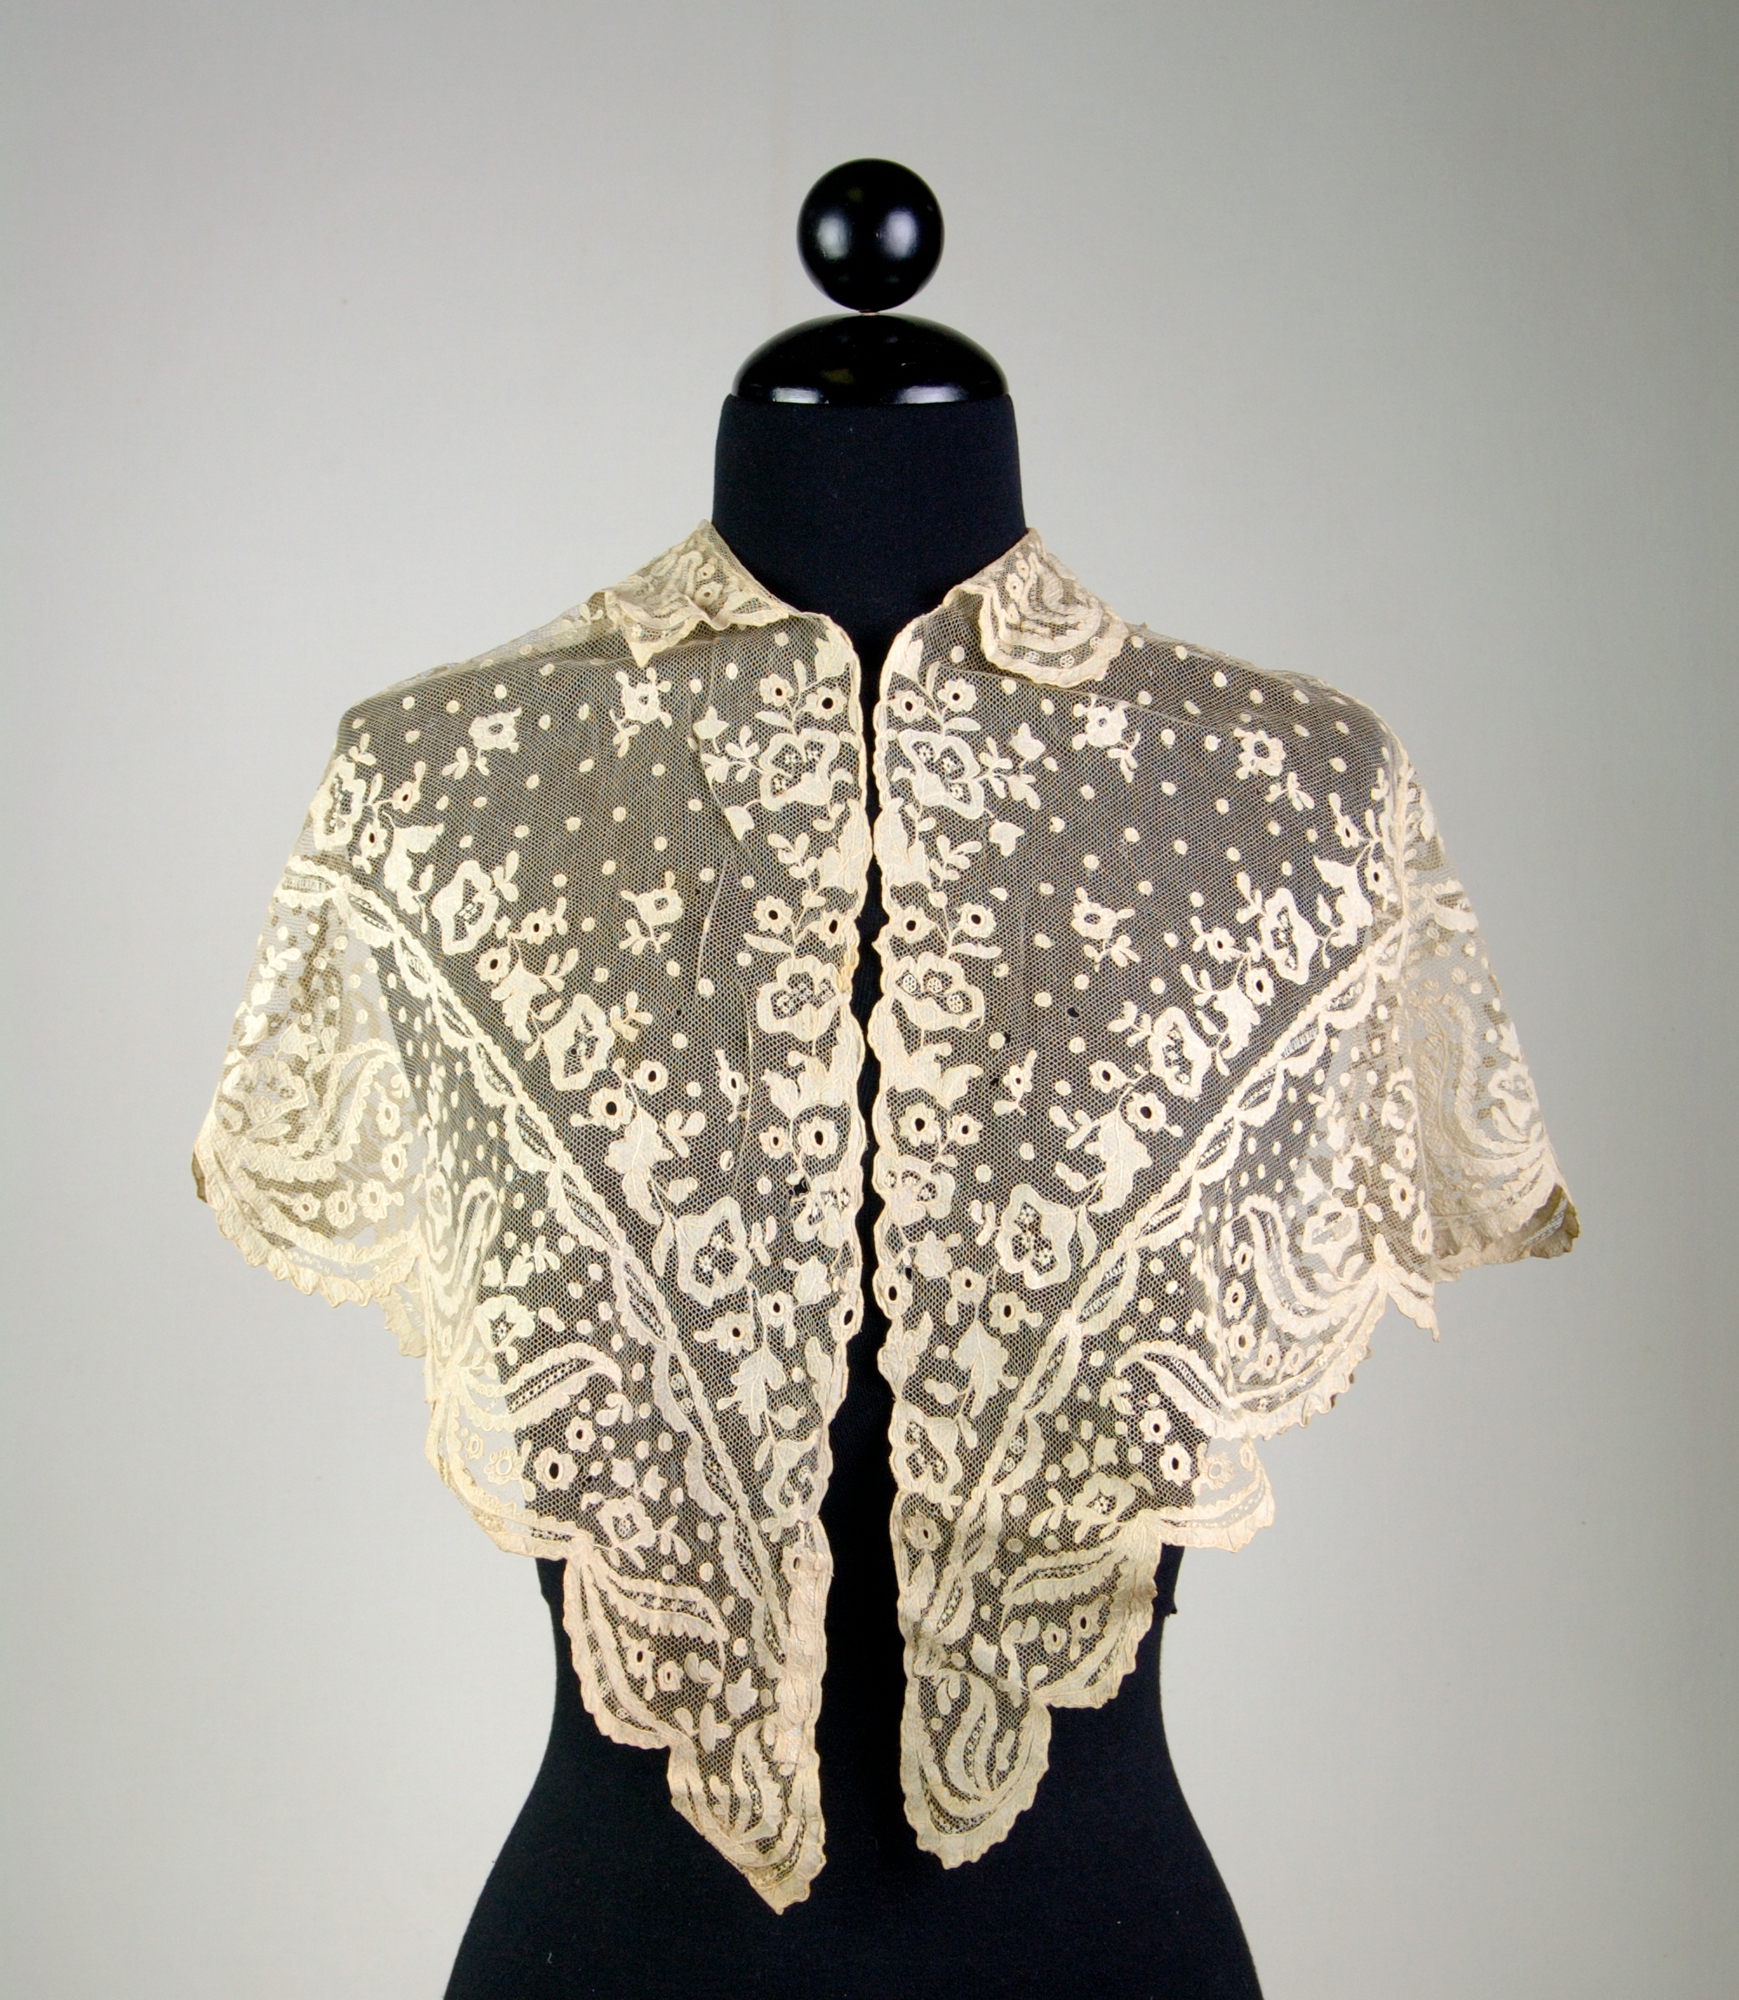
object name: pelerine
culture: irish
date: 1840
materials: cotton